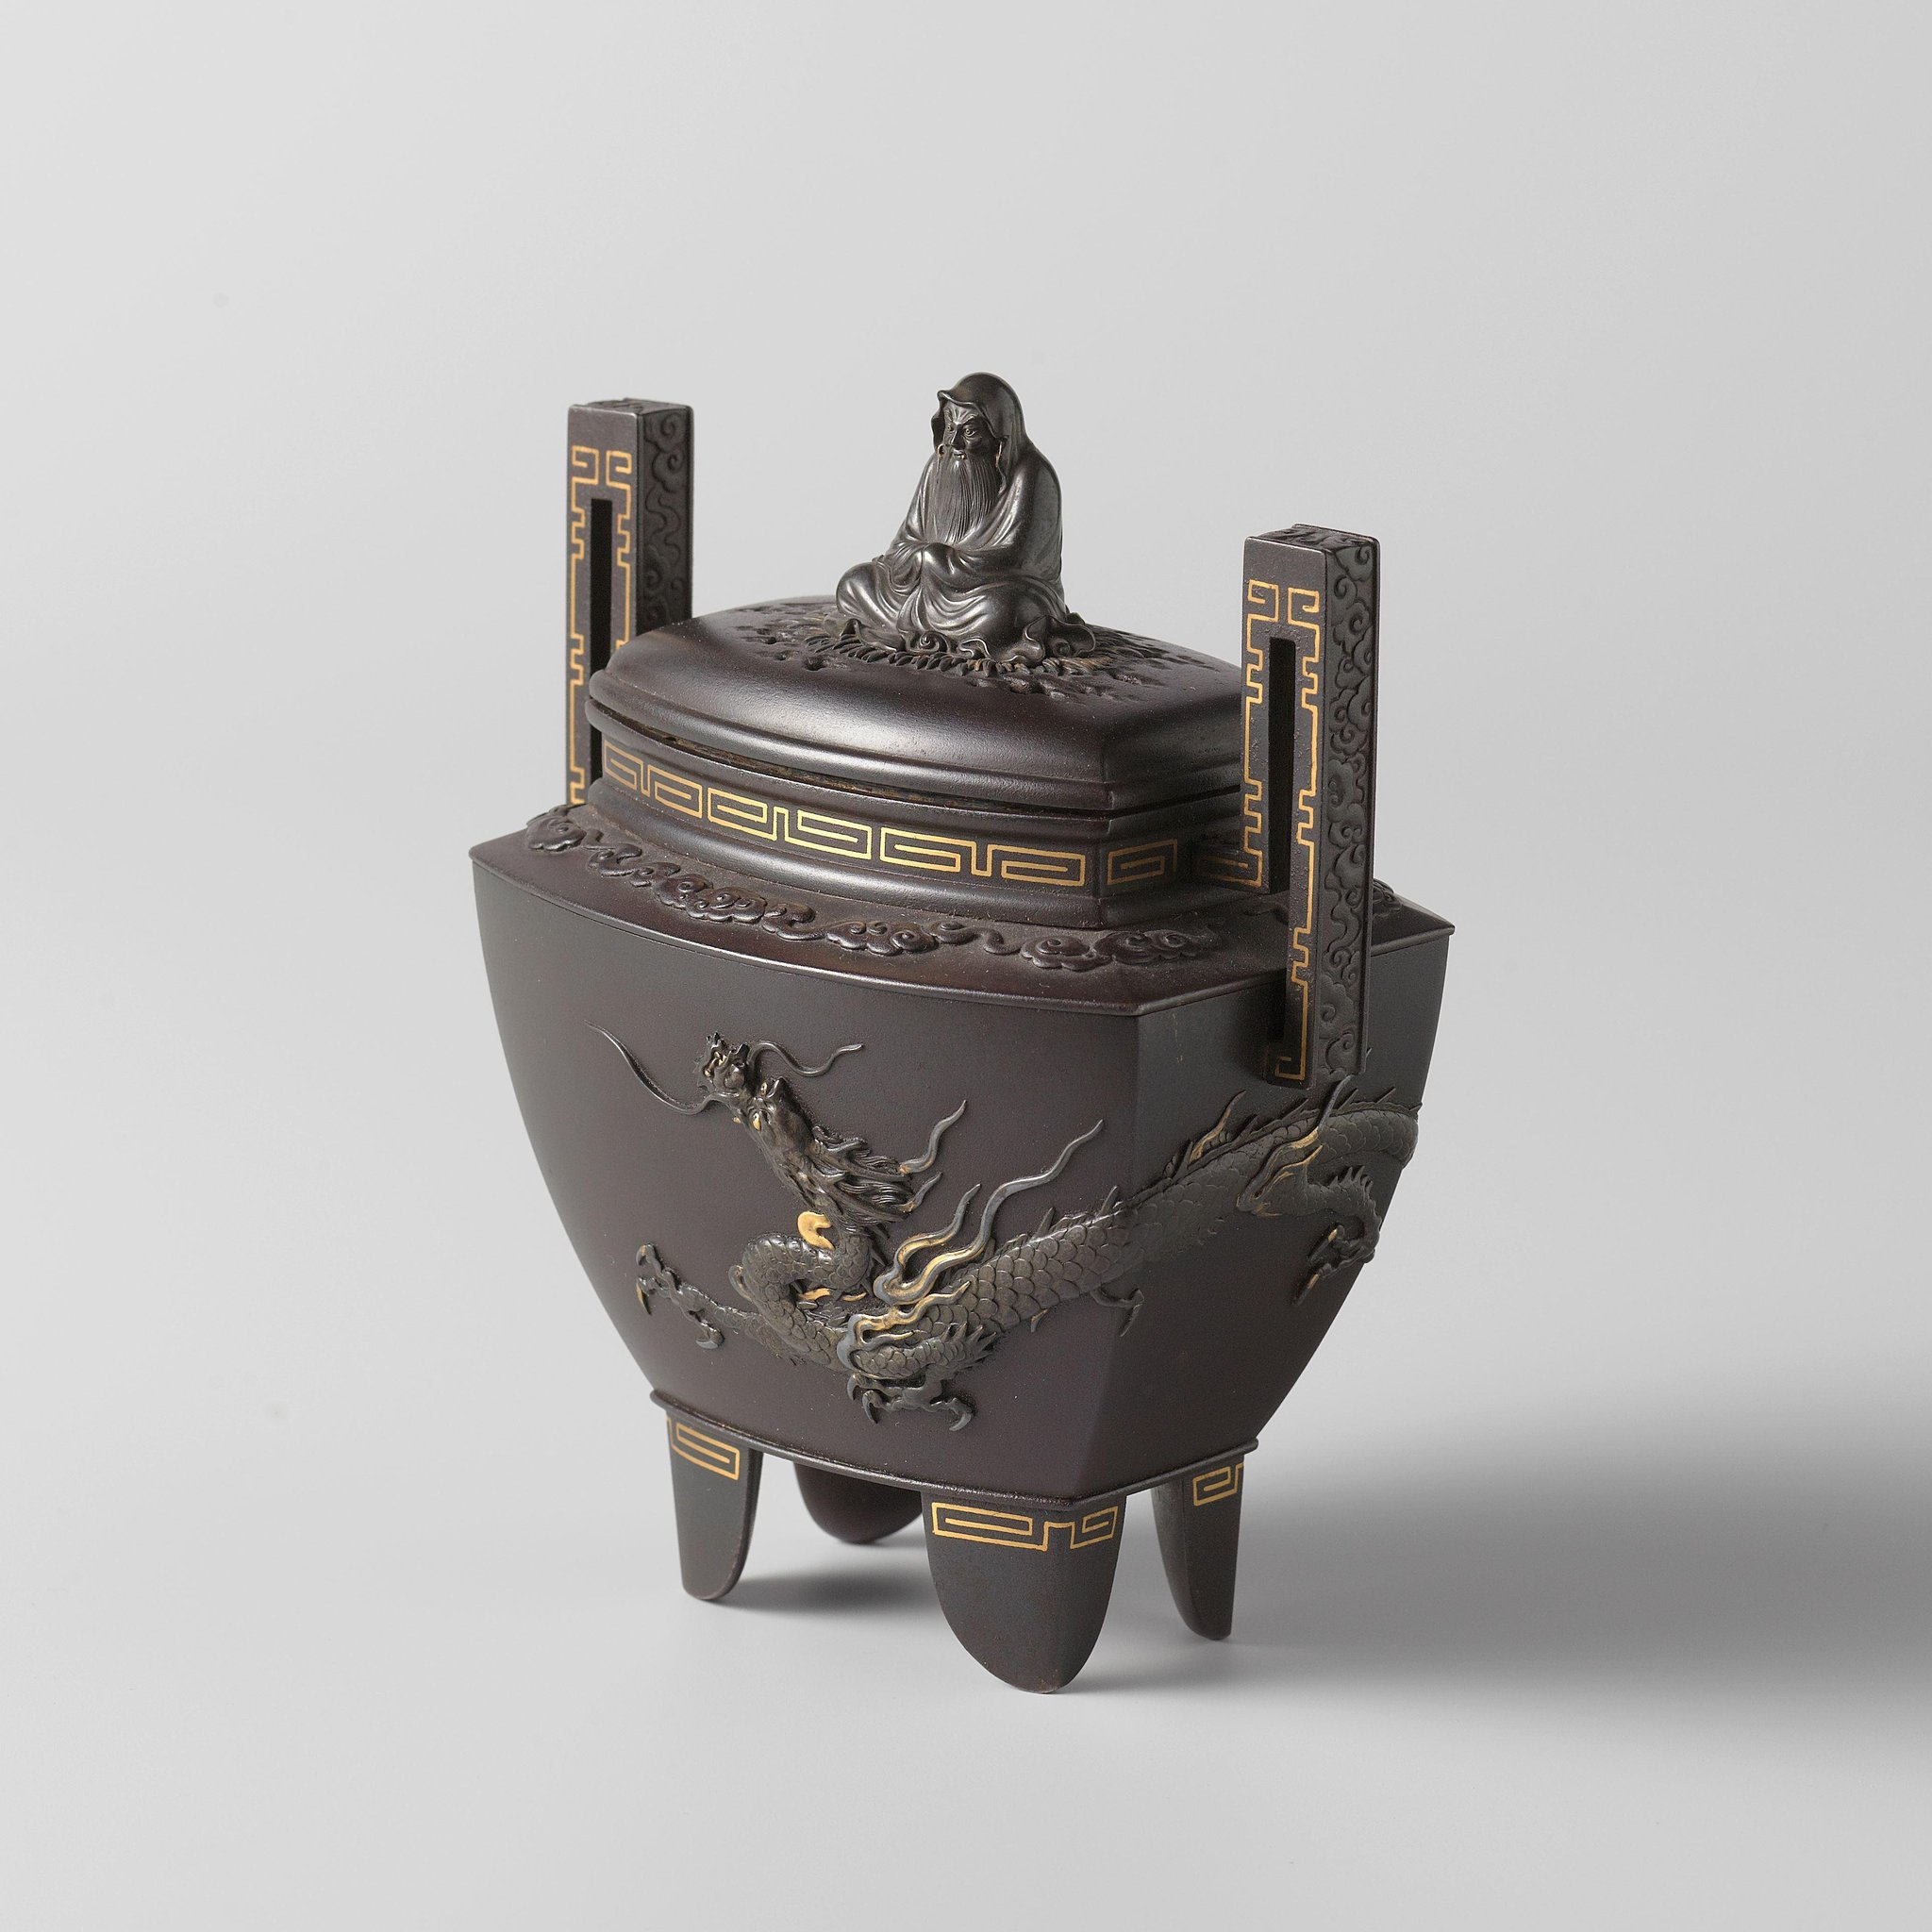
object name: incense burner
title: Deksel van wierookbrander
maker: Anonymous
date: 1850-1899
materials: bronze, gold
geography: japan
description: Op de deksel een zittende man met baard.